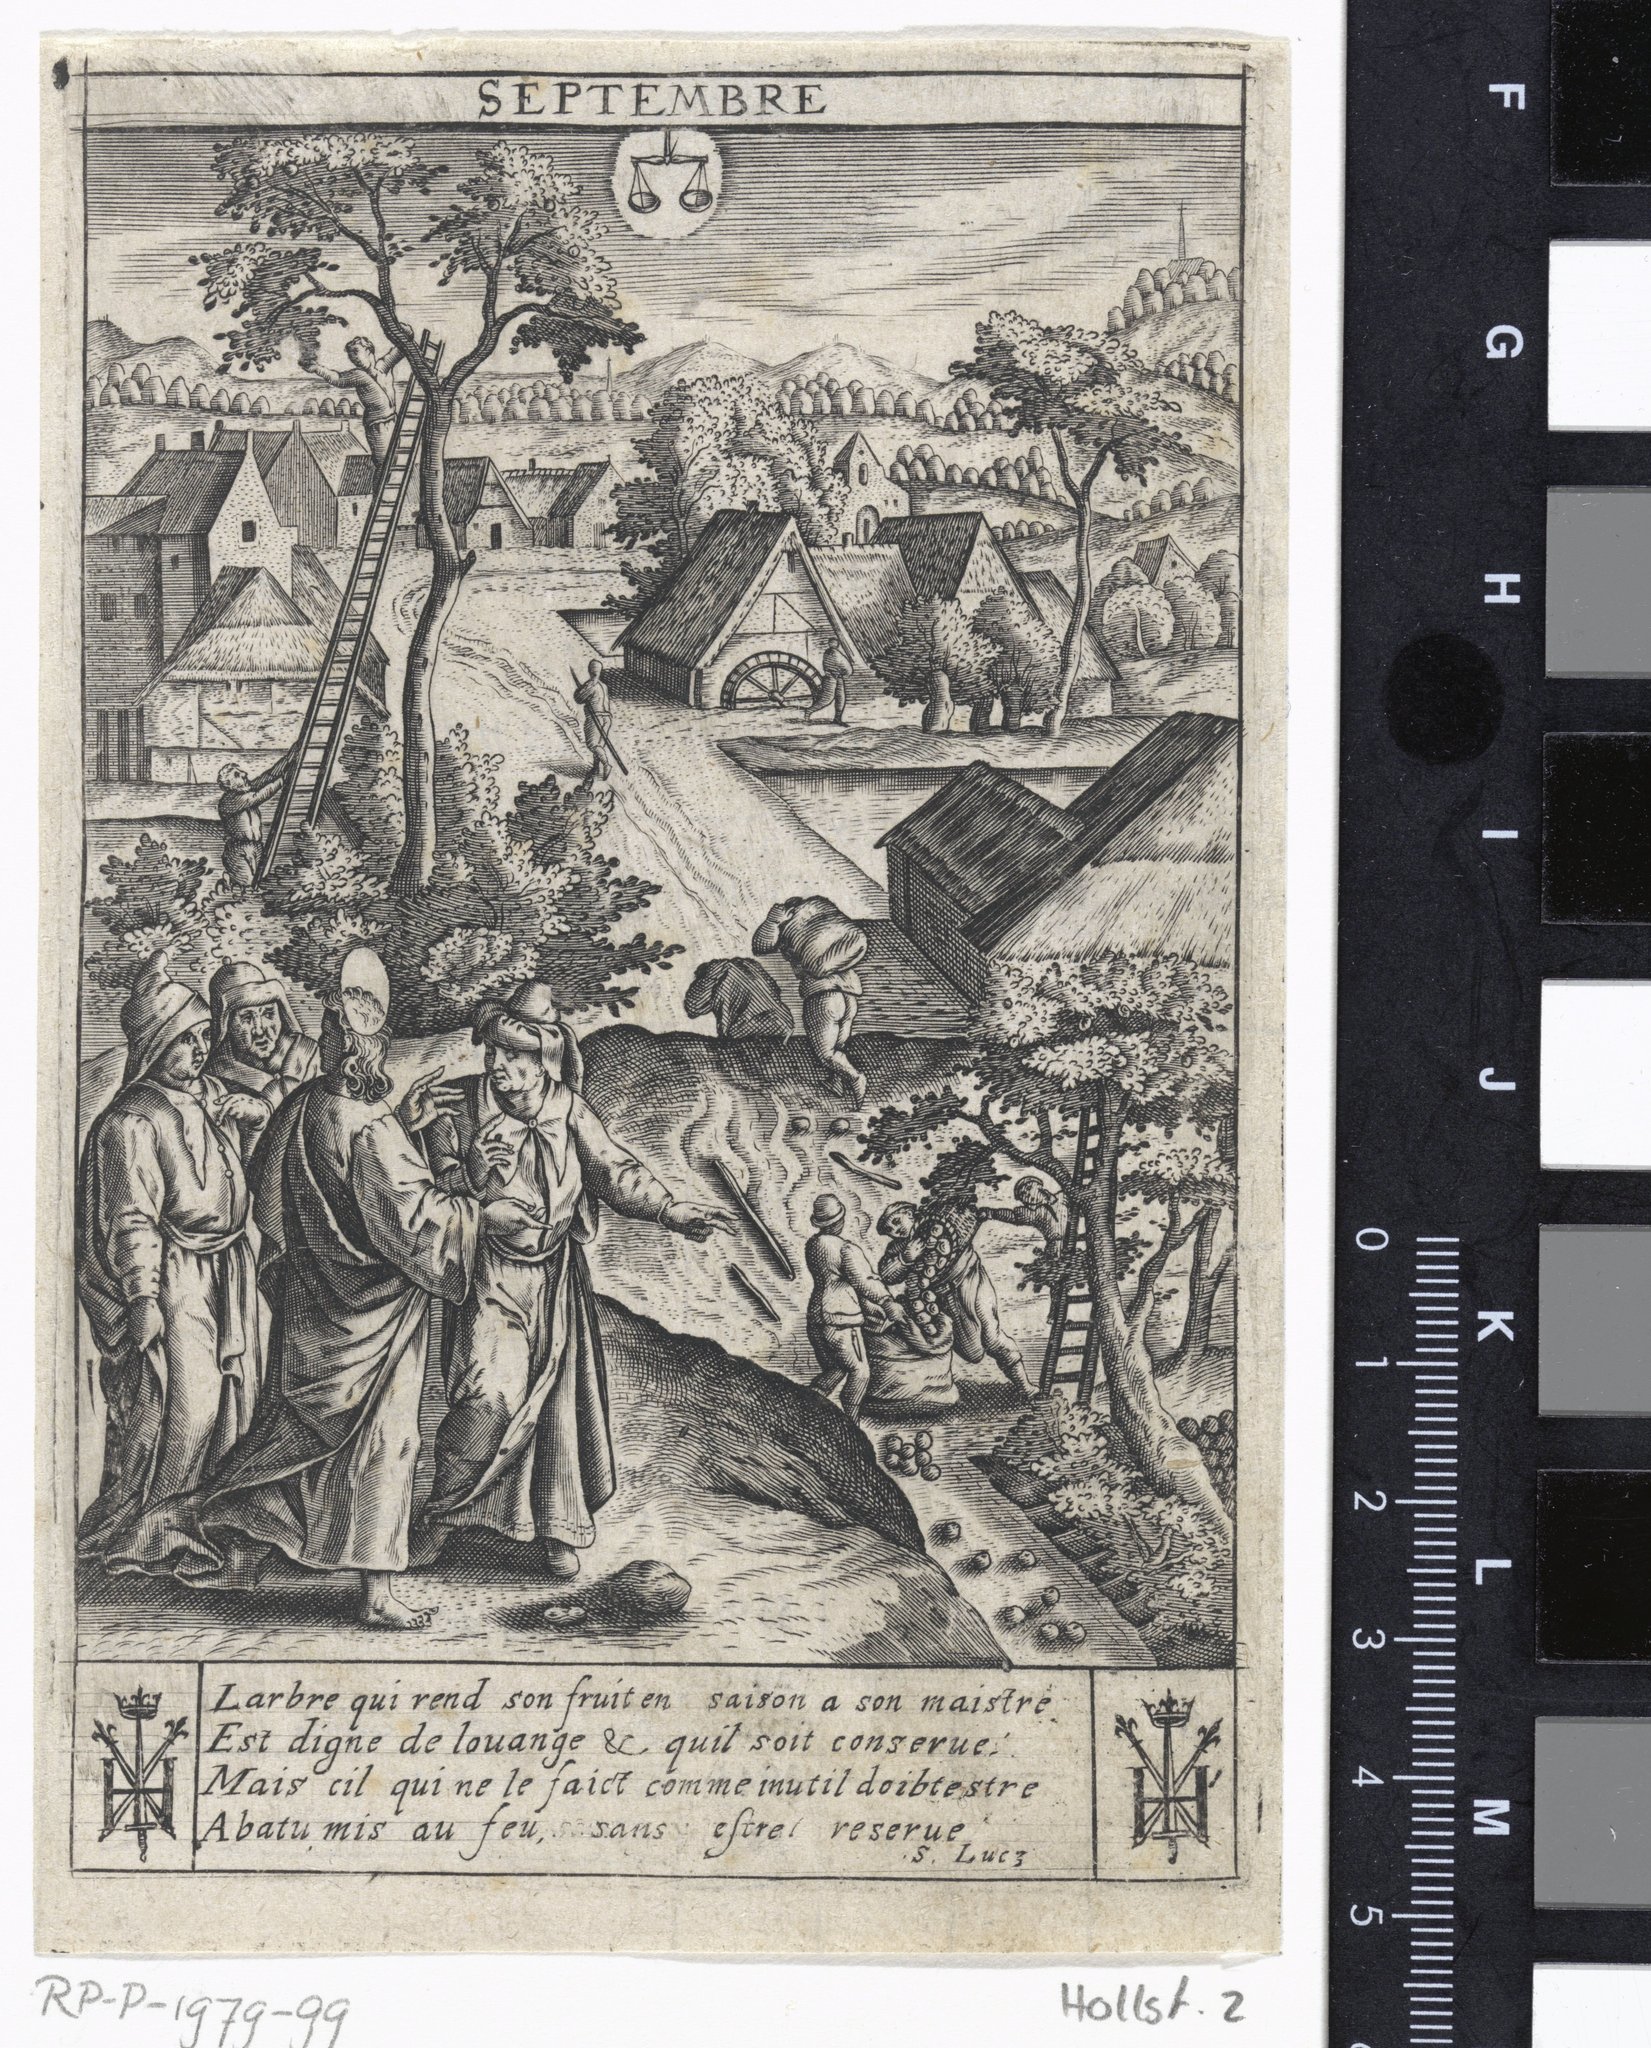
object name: print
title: De twaalf maanden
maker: jan gerritsz swelinck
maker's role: print maker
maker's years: 1600-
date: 1624-1645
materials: paper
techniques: engraving, letterpress printing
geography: amsterdam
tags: landscape symbolizing september, fruit-tree culture; fruit harvest, tree without fruit is cast into the fire ~ proverbial saying of christ (matthew 7:19), libra (zodiacal sign of september)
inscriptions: collector's mark: Lugt 2228, collector's mark: Lugt 2760, collector's mark:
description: Johannes de Doper vertelt de mensen die zich door hem willen laten dopen dat iedere boom die geen goede vruchten draagt, wordt omgehakt en in het vuur geworpen. In het landschap op de achtergrond zijn boeren druk met de fruitoogst. In de lucht het symbool voor het sterrenbeeld Weegschaal. Onder de prent vier versregels in het Frans met een verwijzing naar Luc. 3. Aan weerszijden van de tekst een drukkersmerk. Prent maakt deel uit van een serie met de maanden van het jaar, waarin scènes uit het Nieuwe Testament worden uitgebeeld. Op de achterzijde in rood en zwart een kalender van de betreffende maand in boekdruk.